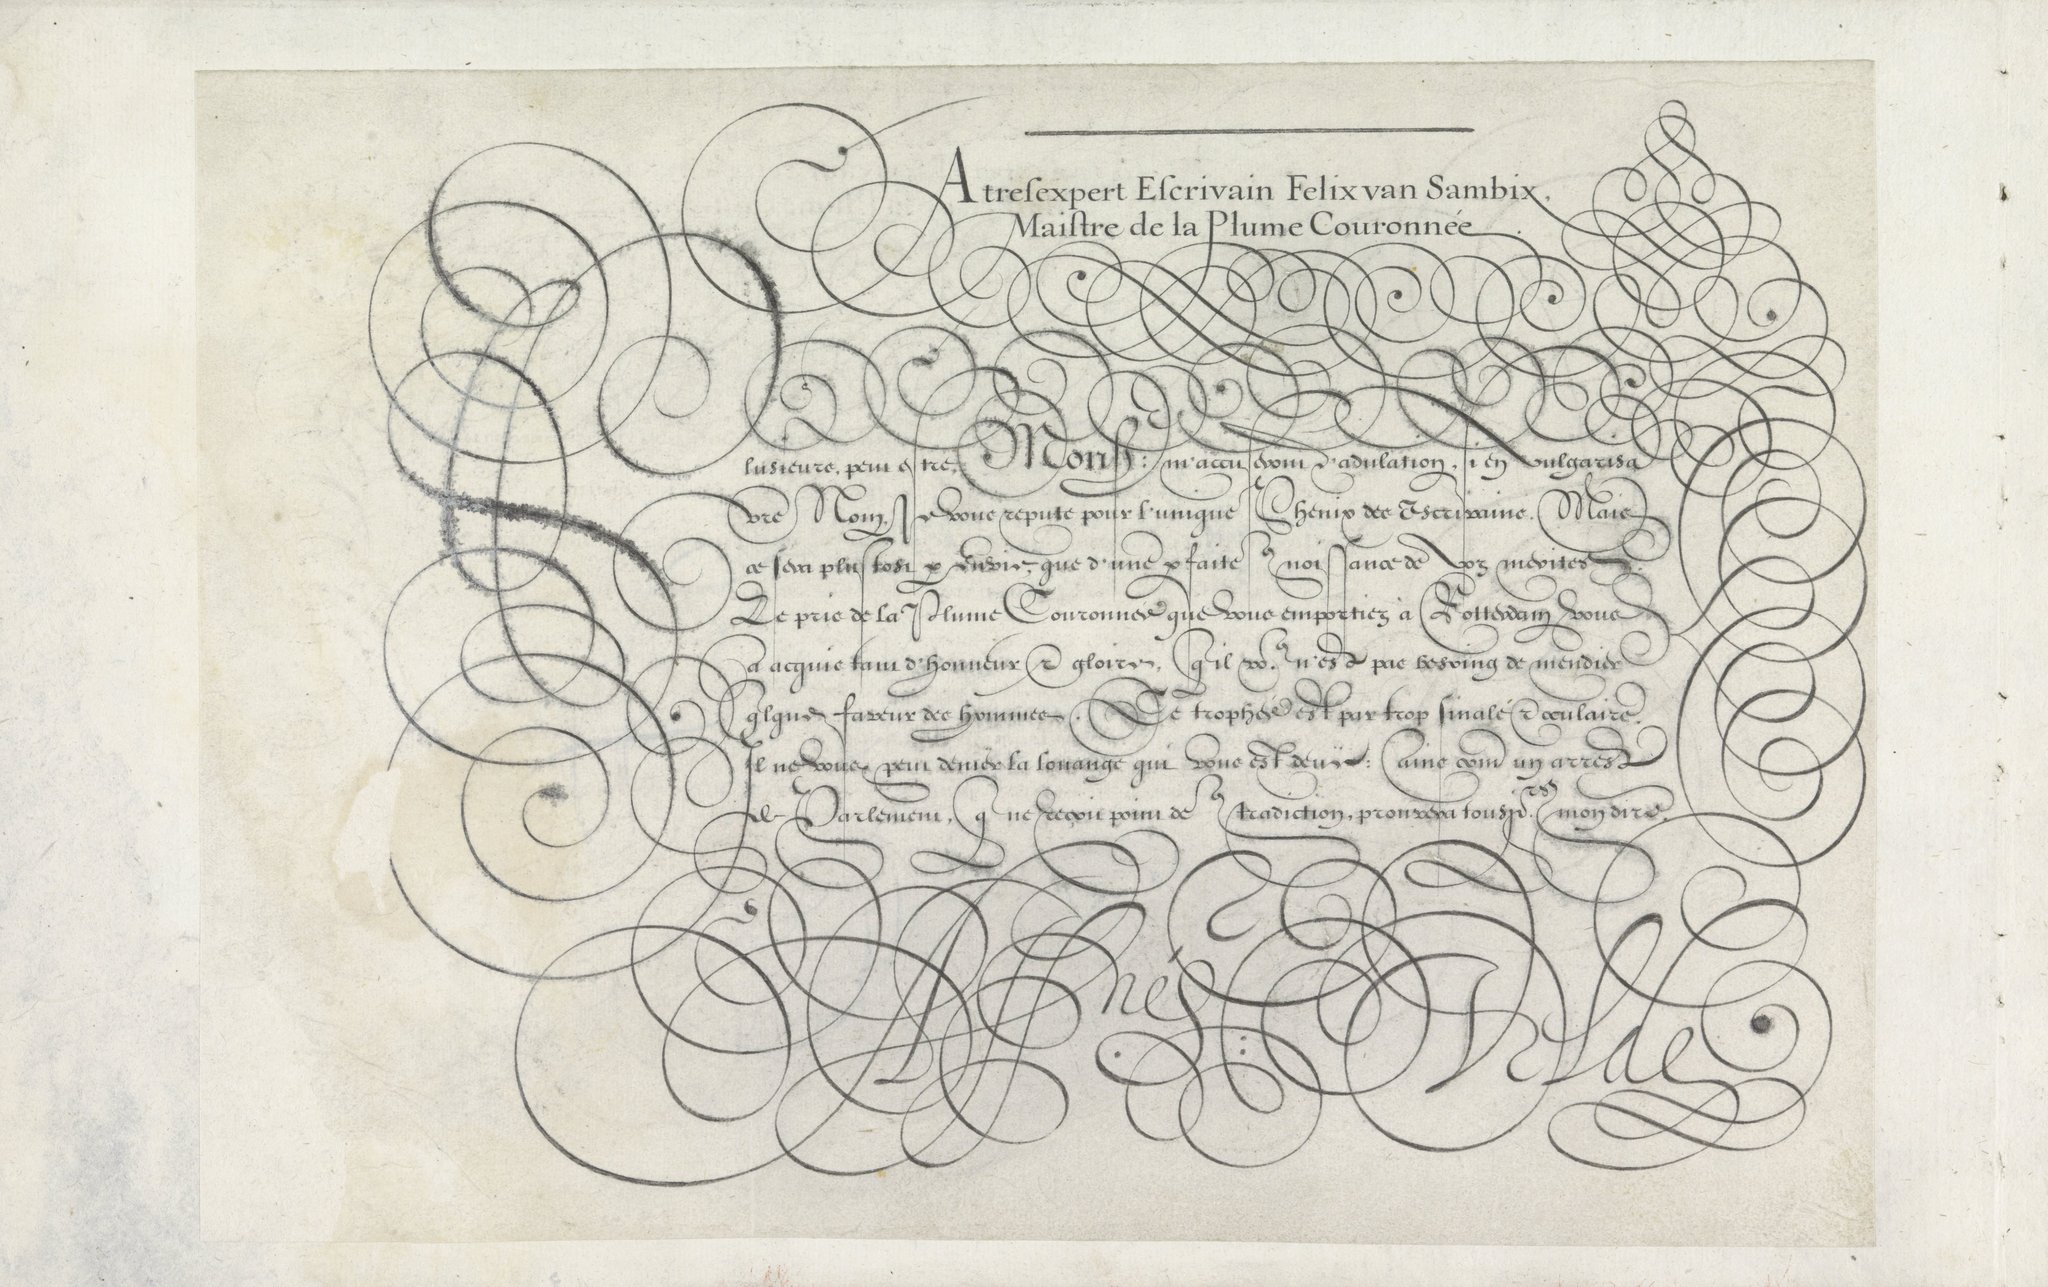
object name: drawing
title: Spieghel der schrijfkonste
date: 1605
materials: ink, paper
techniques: calligraphy, pen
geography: rotterdam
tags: calligraphy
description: Kalligrafische tekening met de aanhef: A tres expert escrivain Felix van Sambix. Maistre de la Plume Couronnée. Daaronder in een andere letter een initiaal P en acht regels tekst in het Frans: Plusieure peut estre ... Onderaan: Aisné Velde. De tekst is omlijst door krulwerk. De tekening maakt deel uit van een album.